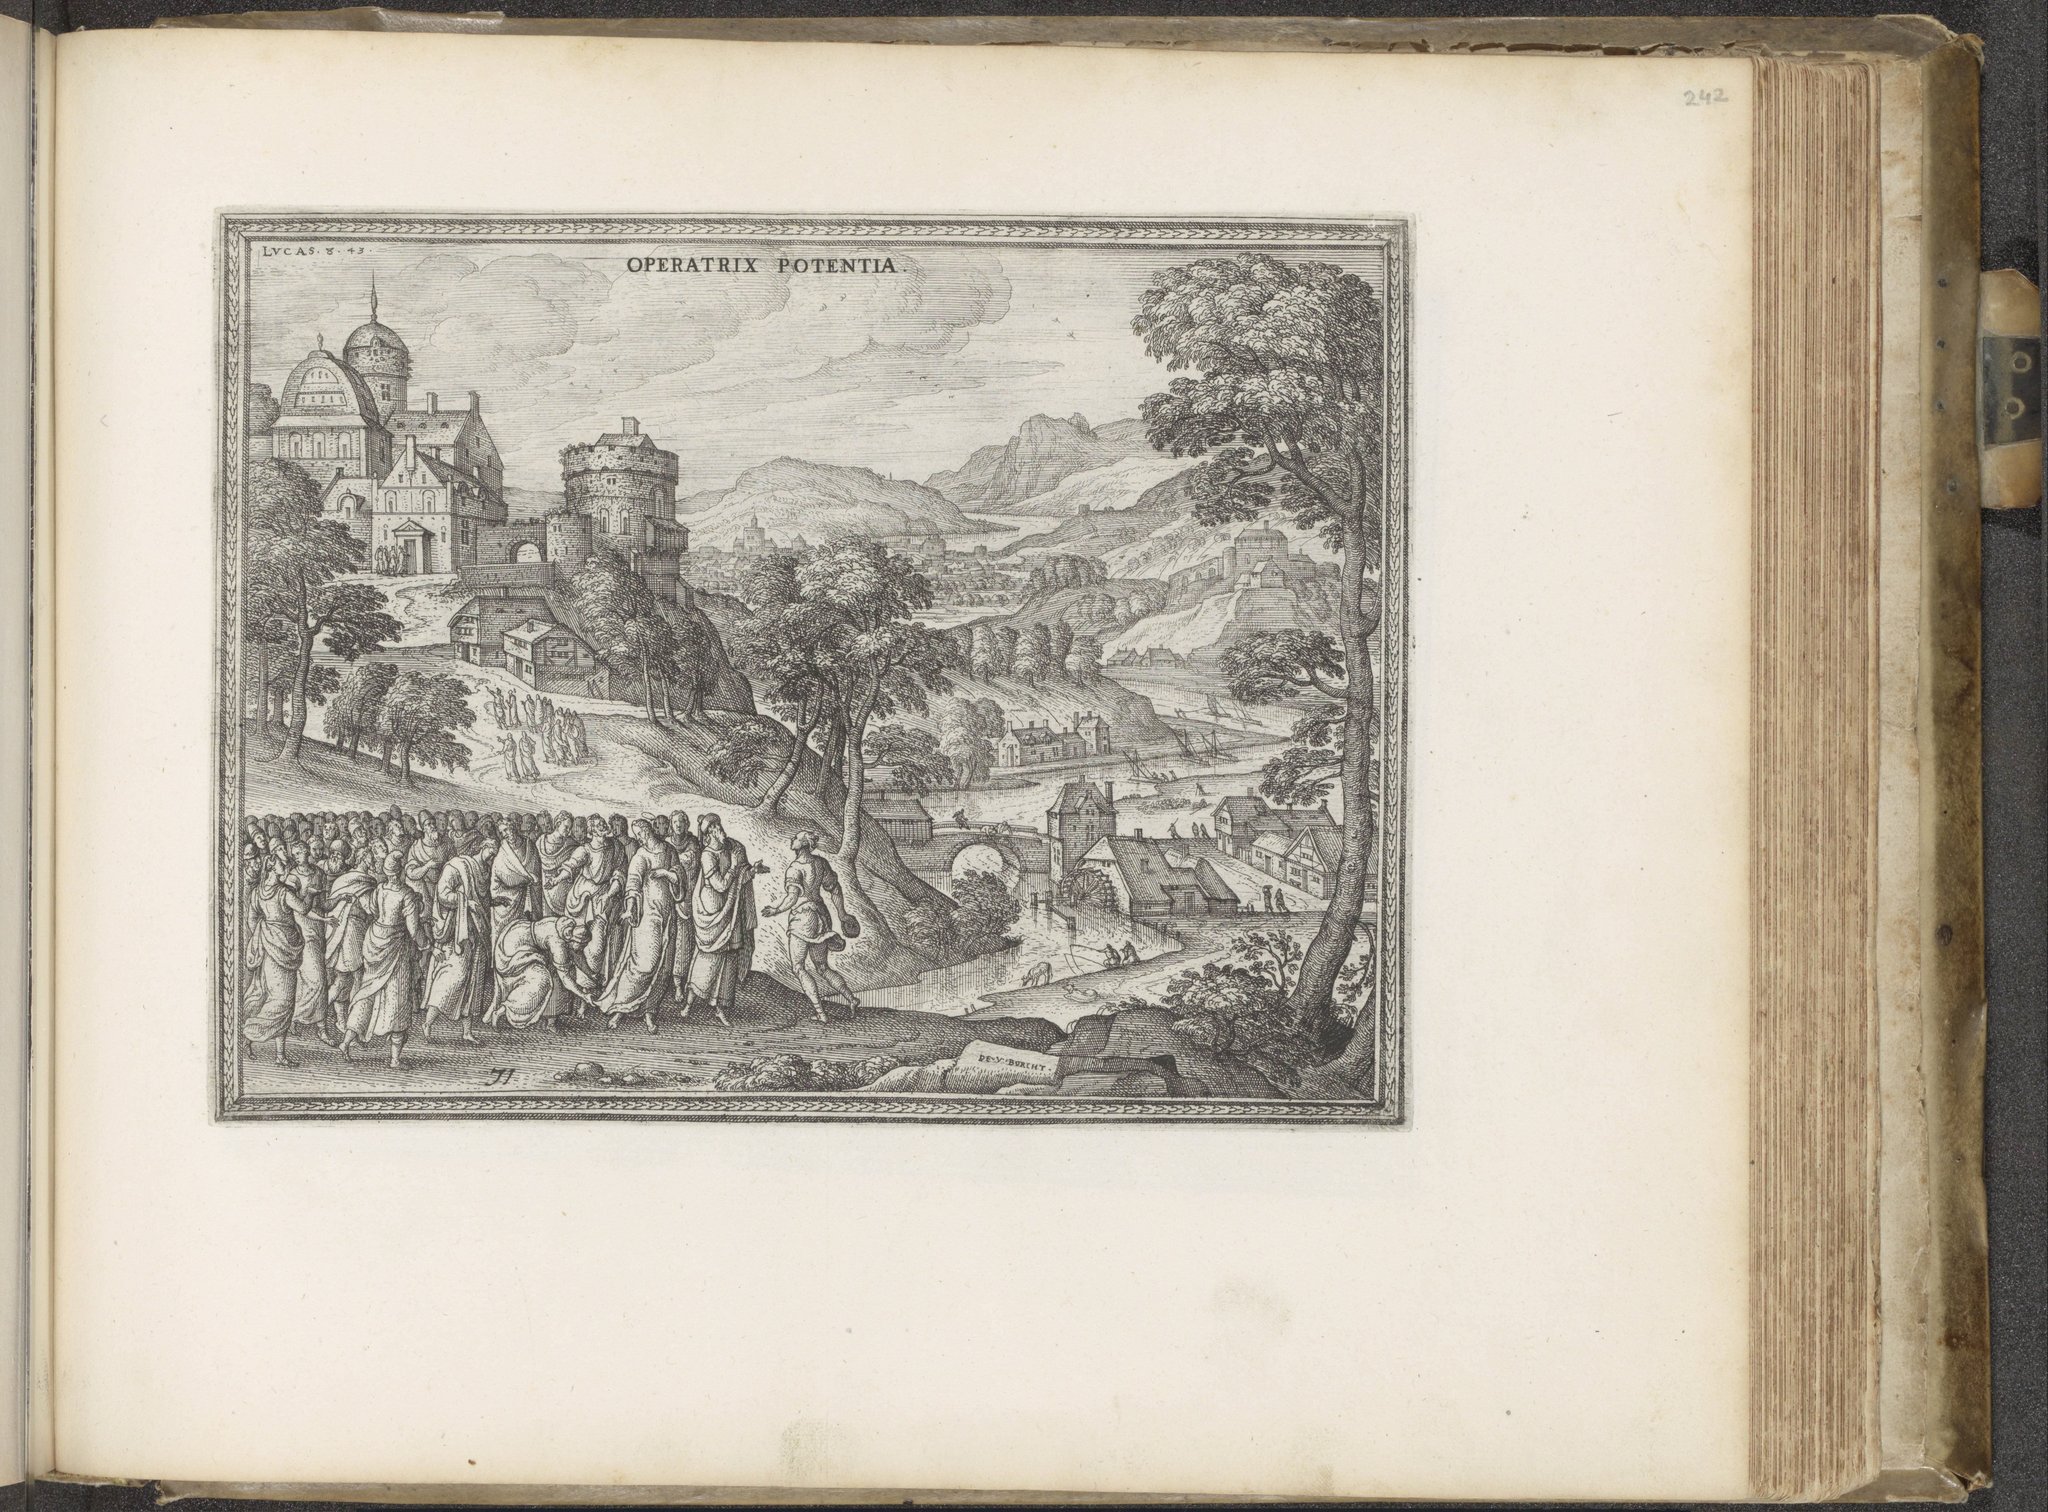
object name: print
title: Operatrix potentia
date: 1582-1593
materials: paper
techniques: etching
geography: amsterdam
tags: city-view, and landscape with man-made constructions, river, healing of a woman with an issue of blood: she kneels before christ after having touched his robe (matthew 9:20-22; mark 5:25-34; luke 8:43-48)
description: Rivierlandschap met gebouw op een berg. Een vrouw die al twaalf jaar aan bloedverlies leed nadert Christus van achteren en raakte de zoom van zijn bovenkleed aan (Luc. 8:43). De prent maakt deel uit van een album.